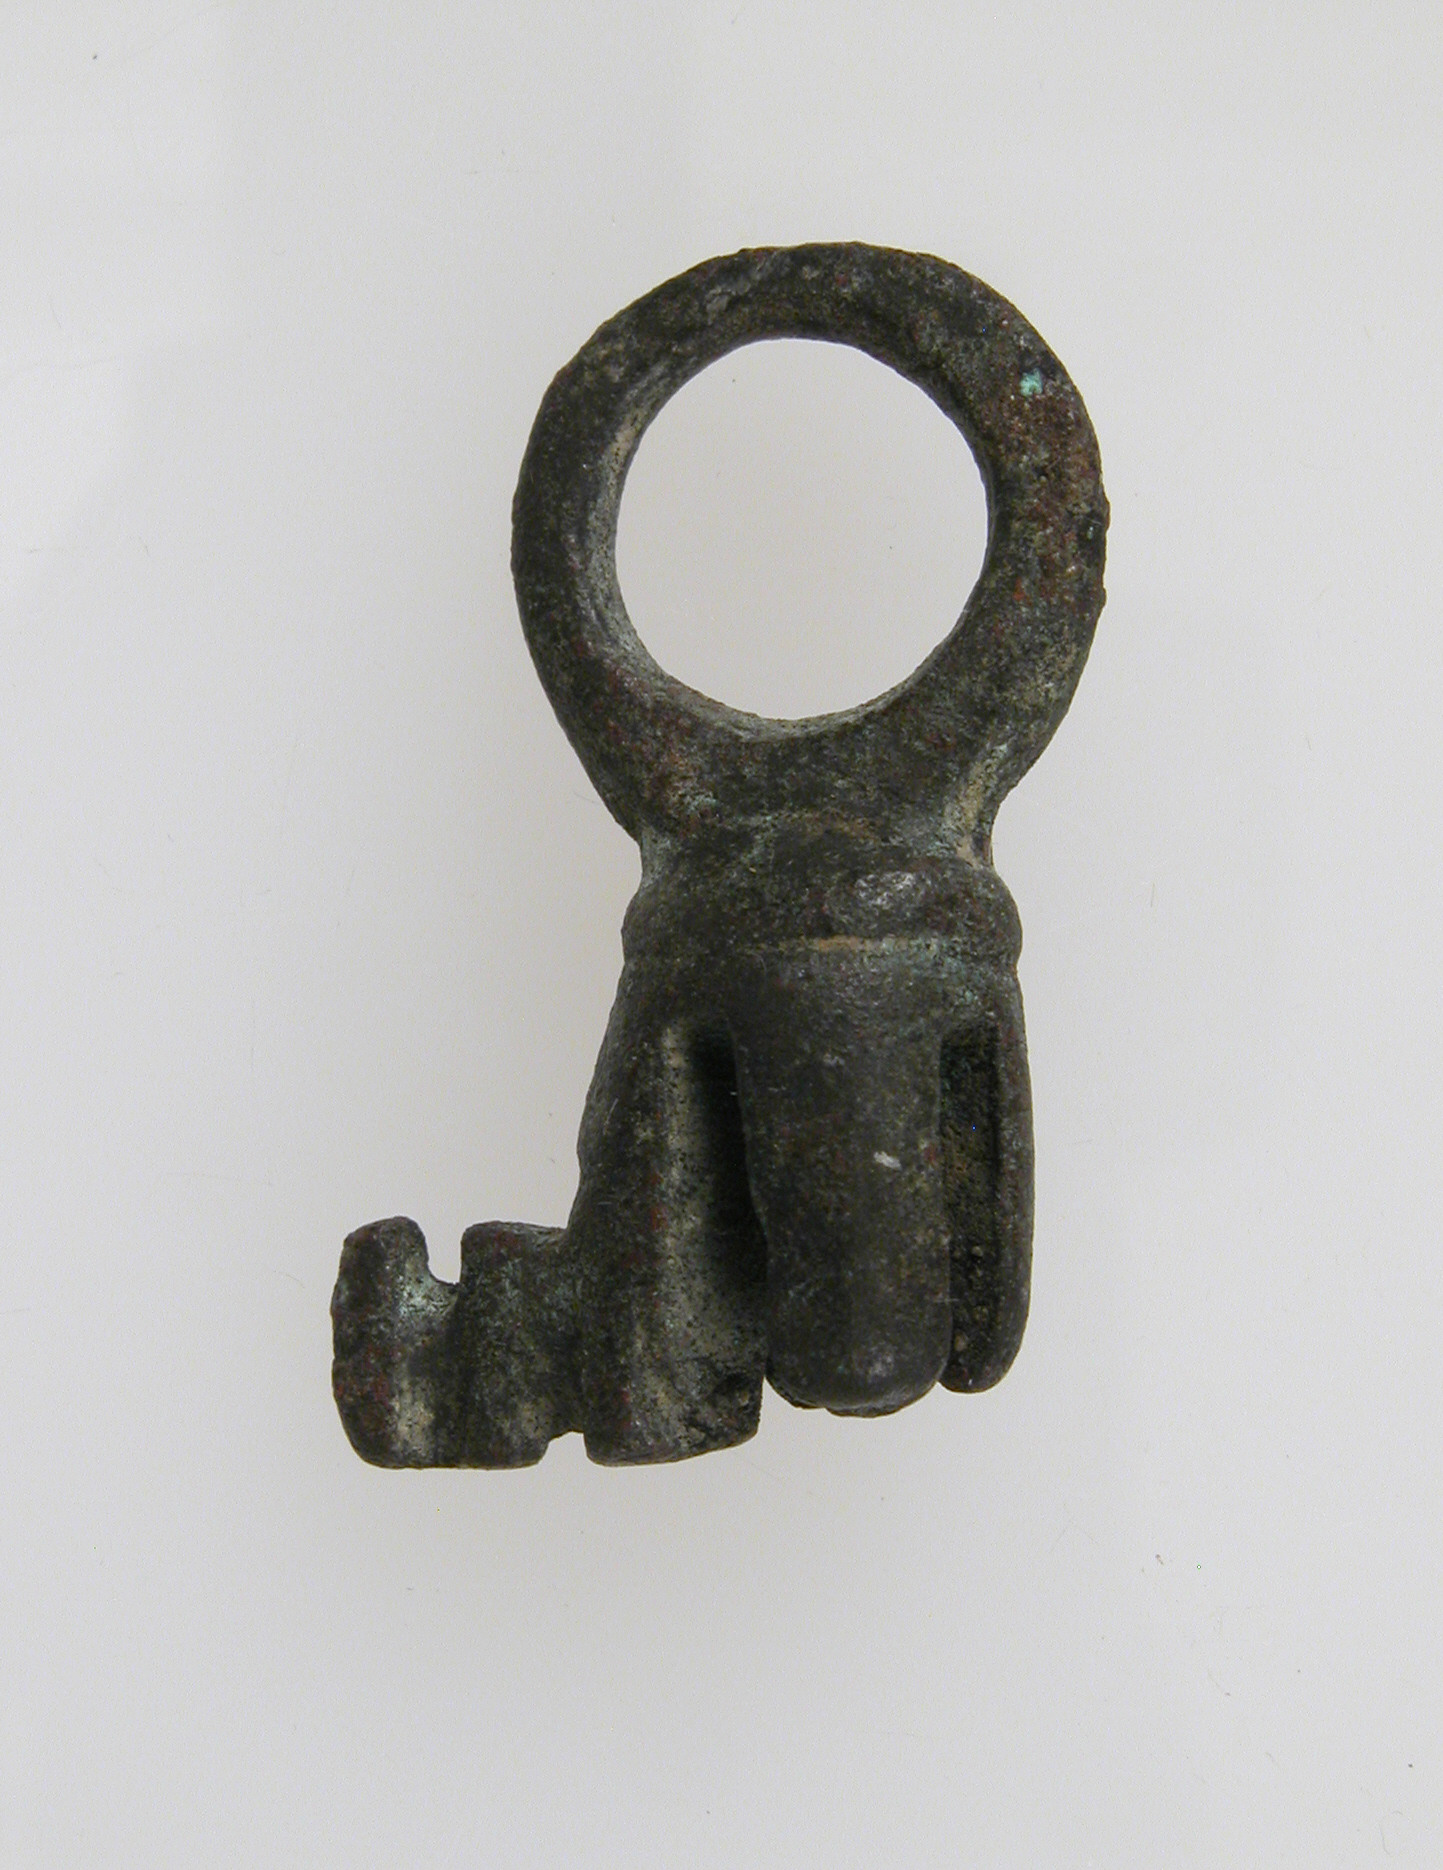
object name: key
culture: roman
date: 1-700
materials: copper alloy